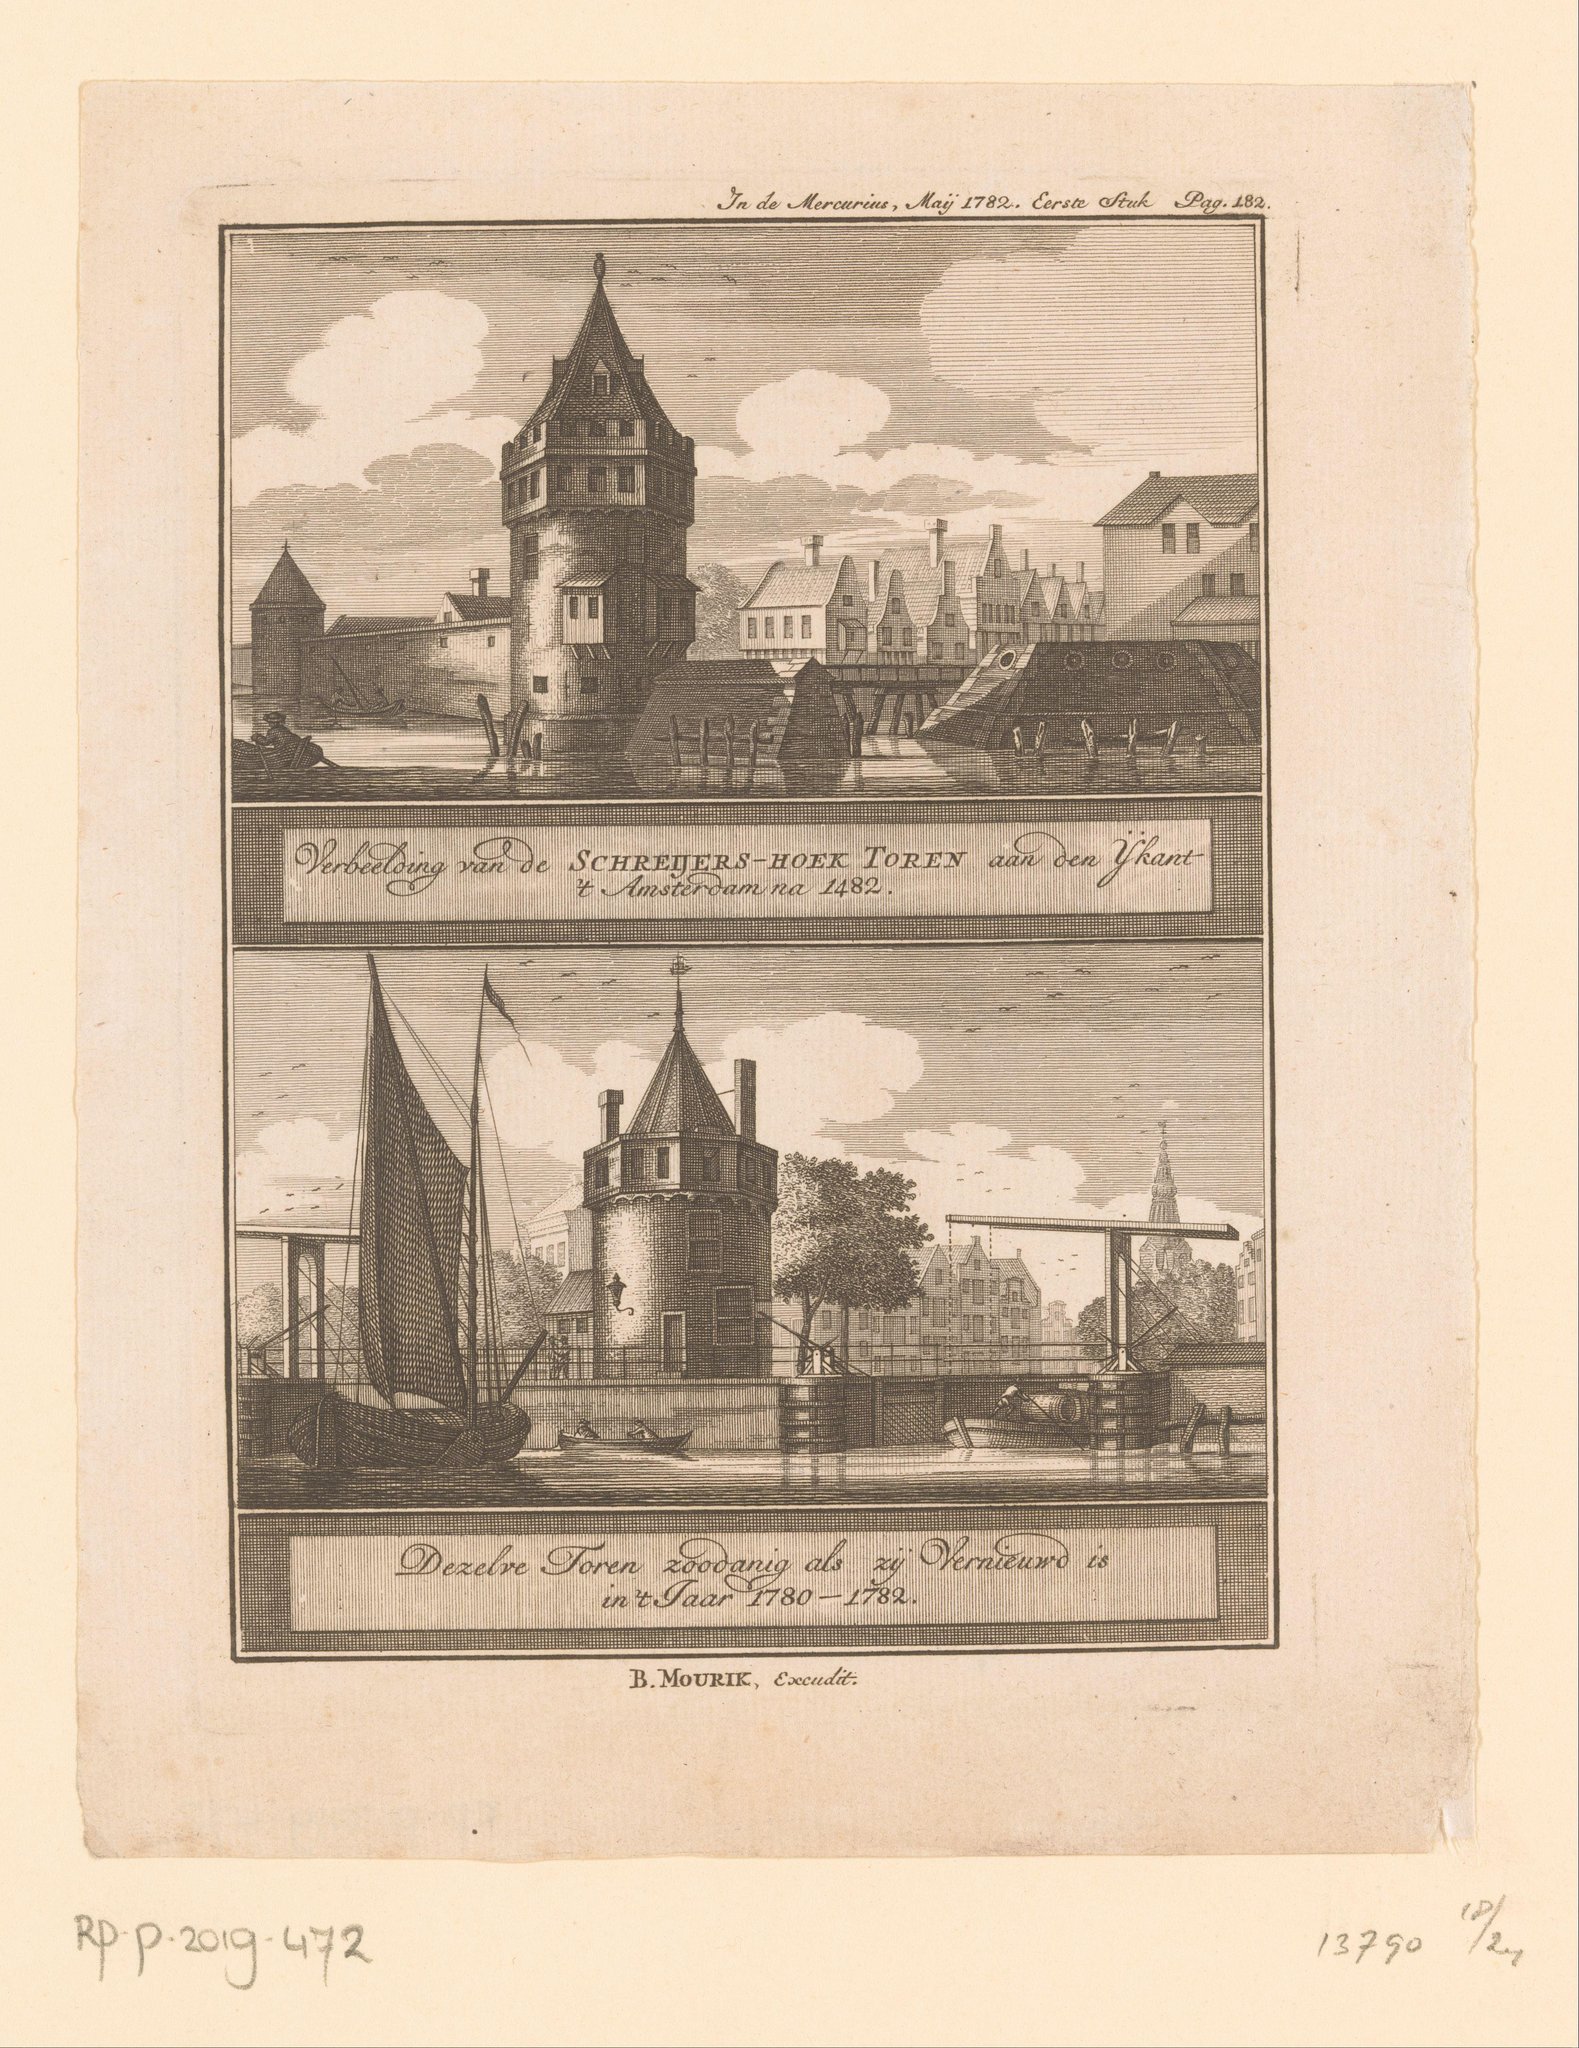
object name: book illustration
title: Verbeelding van de Schreijers-hoek Toren aan den IJkant 't Amsterdam na 1482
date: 1782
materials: paper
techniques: engraving, etching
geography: amsterdam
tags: urban housing, sailing-ship, sailing-boat, towers ~ fortified city, rowing-boat, canoe, etc., bridge in city across river, canal, etc.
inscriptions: date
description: Prent uit: De maandelykse Nederlandsche Mercurius (...) 52 (1782), p. 182.